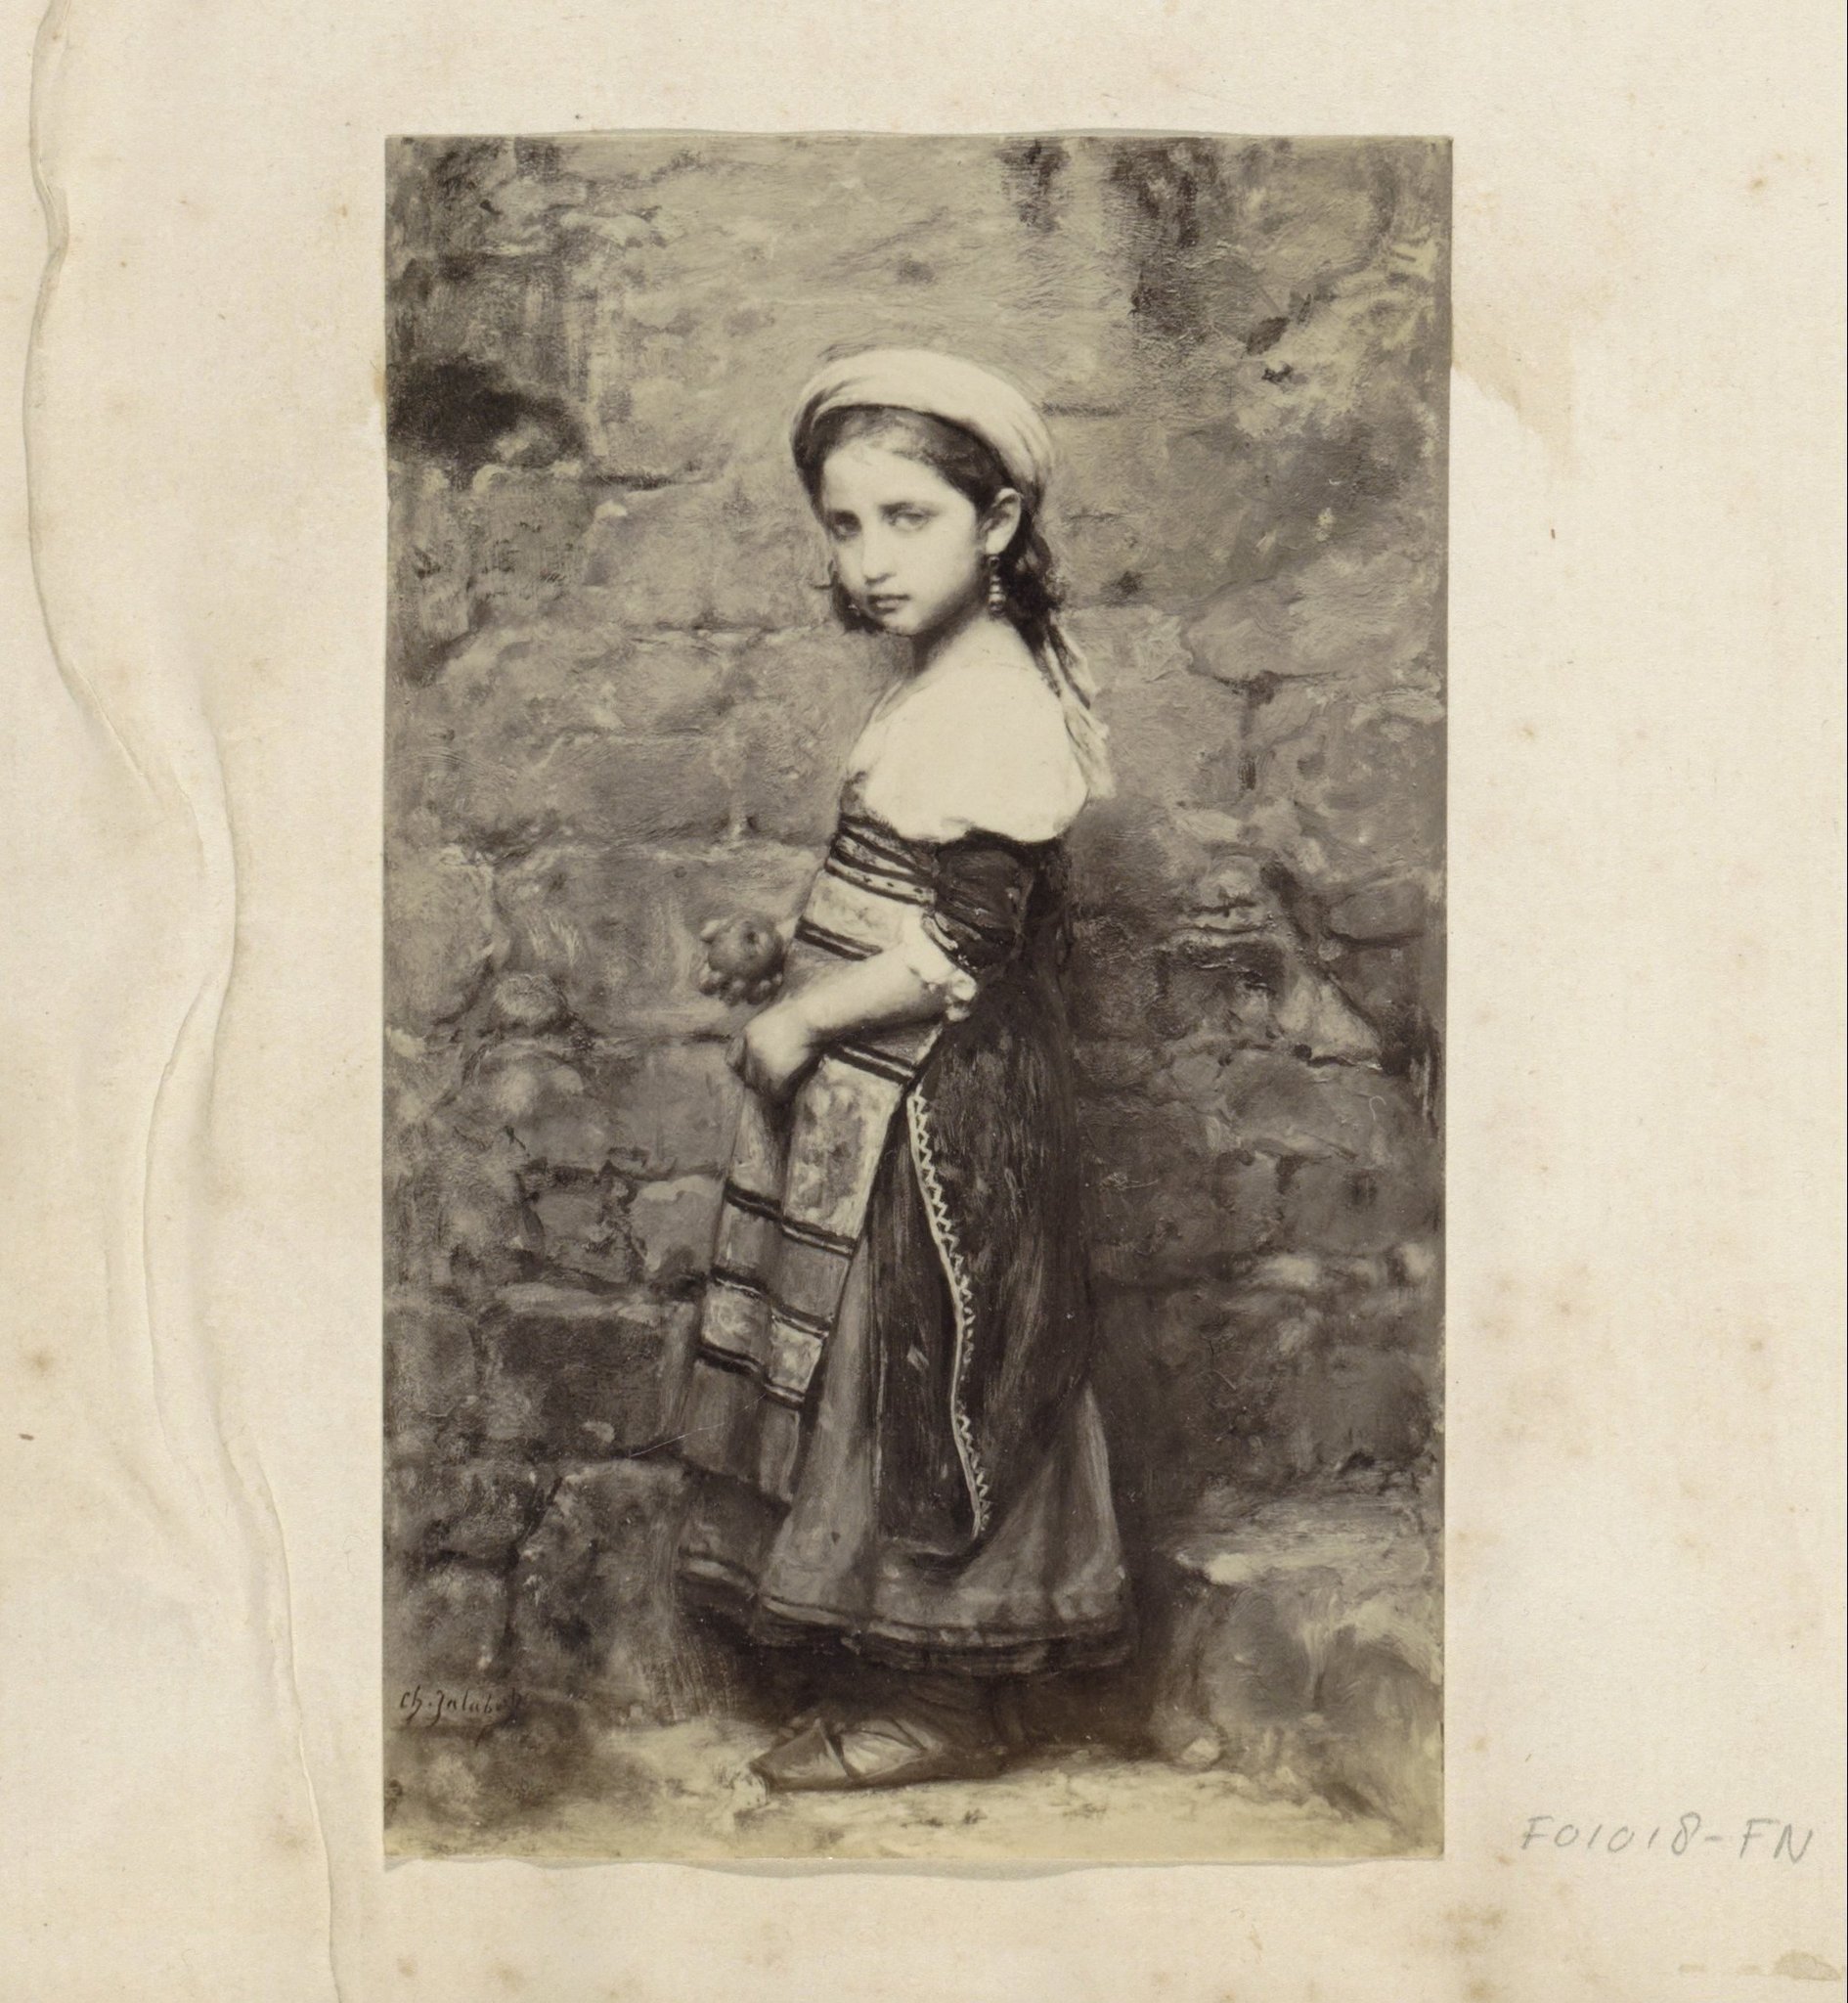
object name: photograph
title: Fotoreproductie van (vermoedelijk) een prent naar een schilderij van Charles François Jalabert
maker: Anonymous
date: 1860-1870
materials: paper, photographic support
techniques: albumen print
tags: fruits: apple, apron (+ girls' clothes), child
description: Onderdeel van Engels familiealbum met foto's van personen, reizen, cricket en kunstwerken.